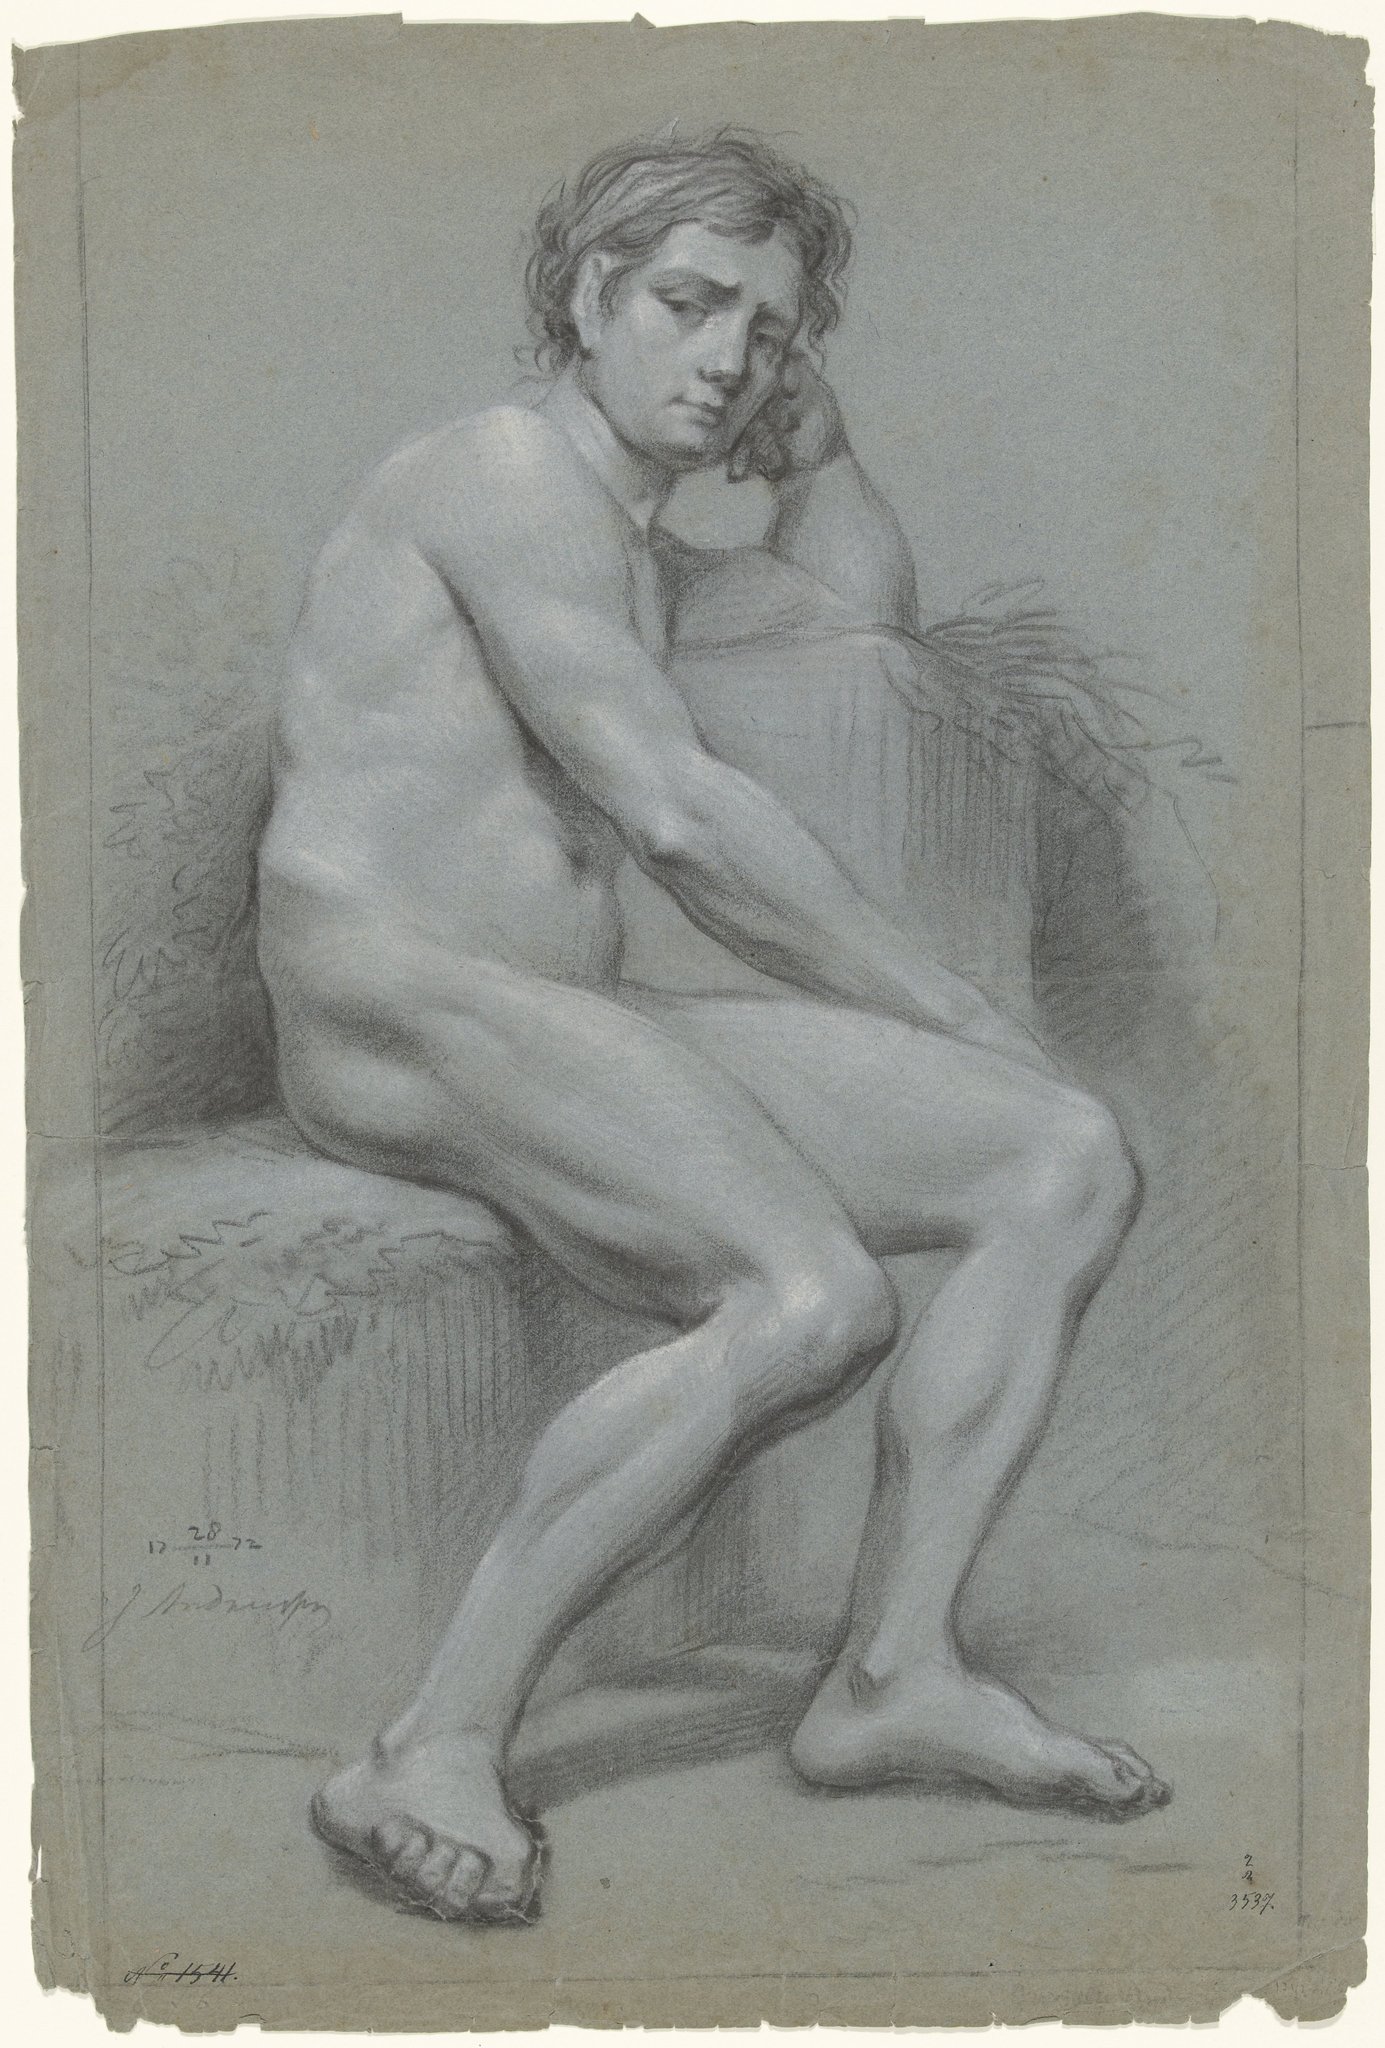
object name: drawing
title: Zittend mannelijk naakt, de linkerhand onder het hoofd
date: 1772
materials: chalk, paper